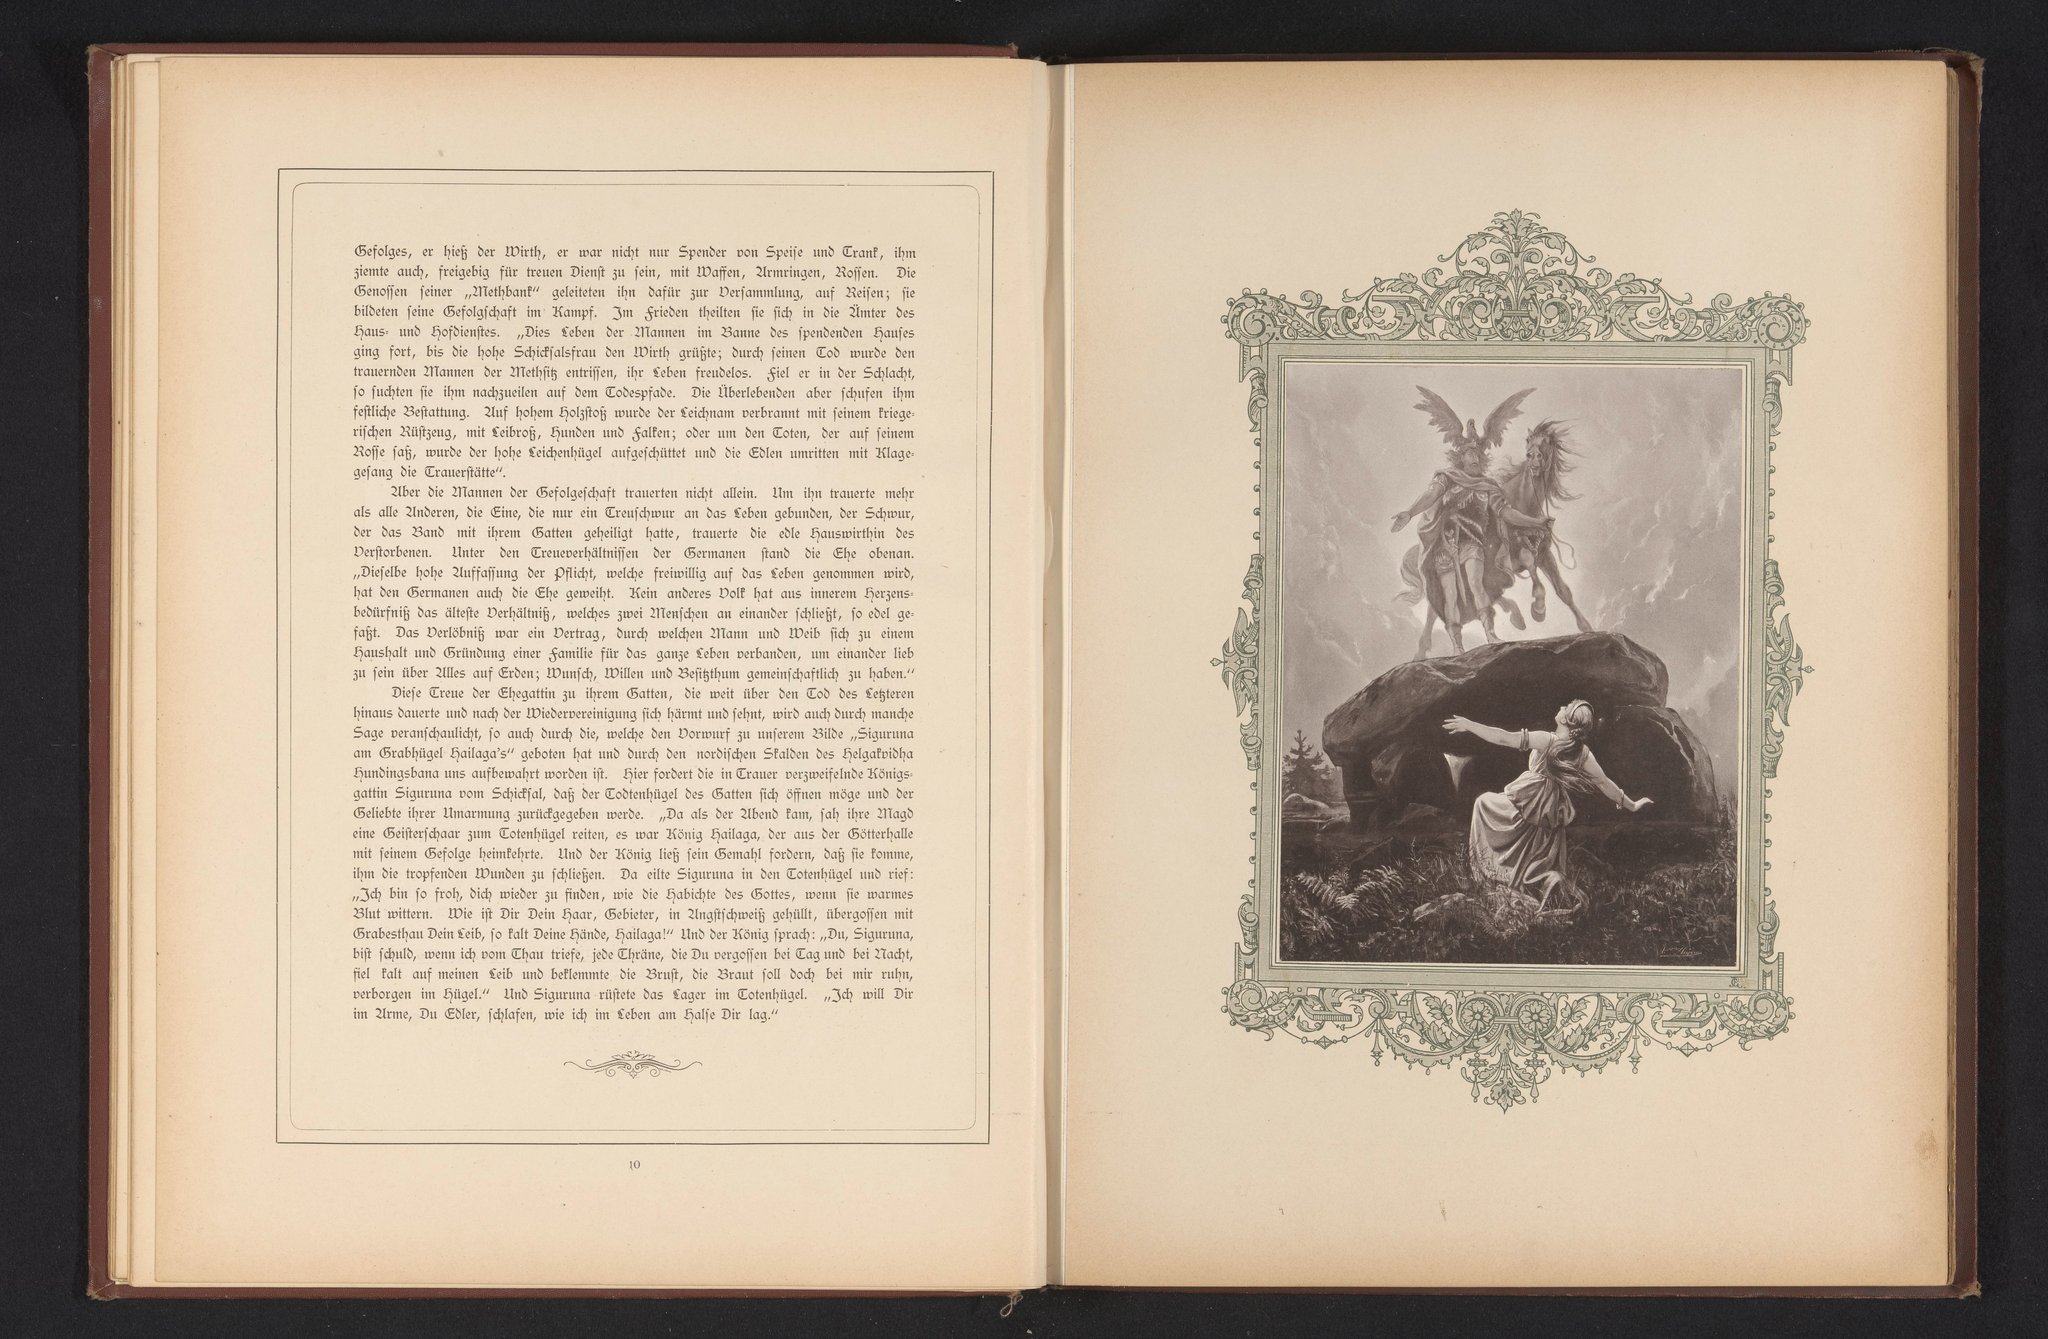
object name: reproduction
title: Fotoreproductie van een schilderij voorstellende Siguruna bij de grafheuvel van Hailaga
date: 1877-1882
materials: paper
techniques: photograph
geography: germany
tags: grave, tomb